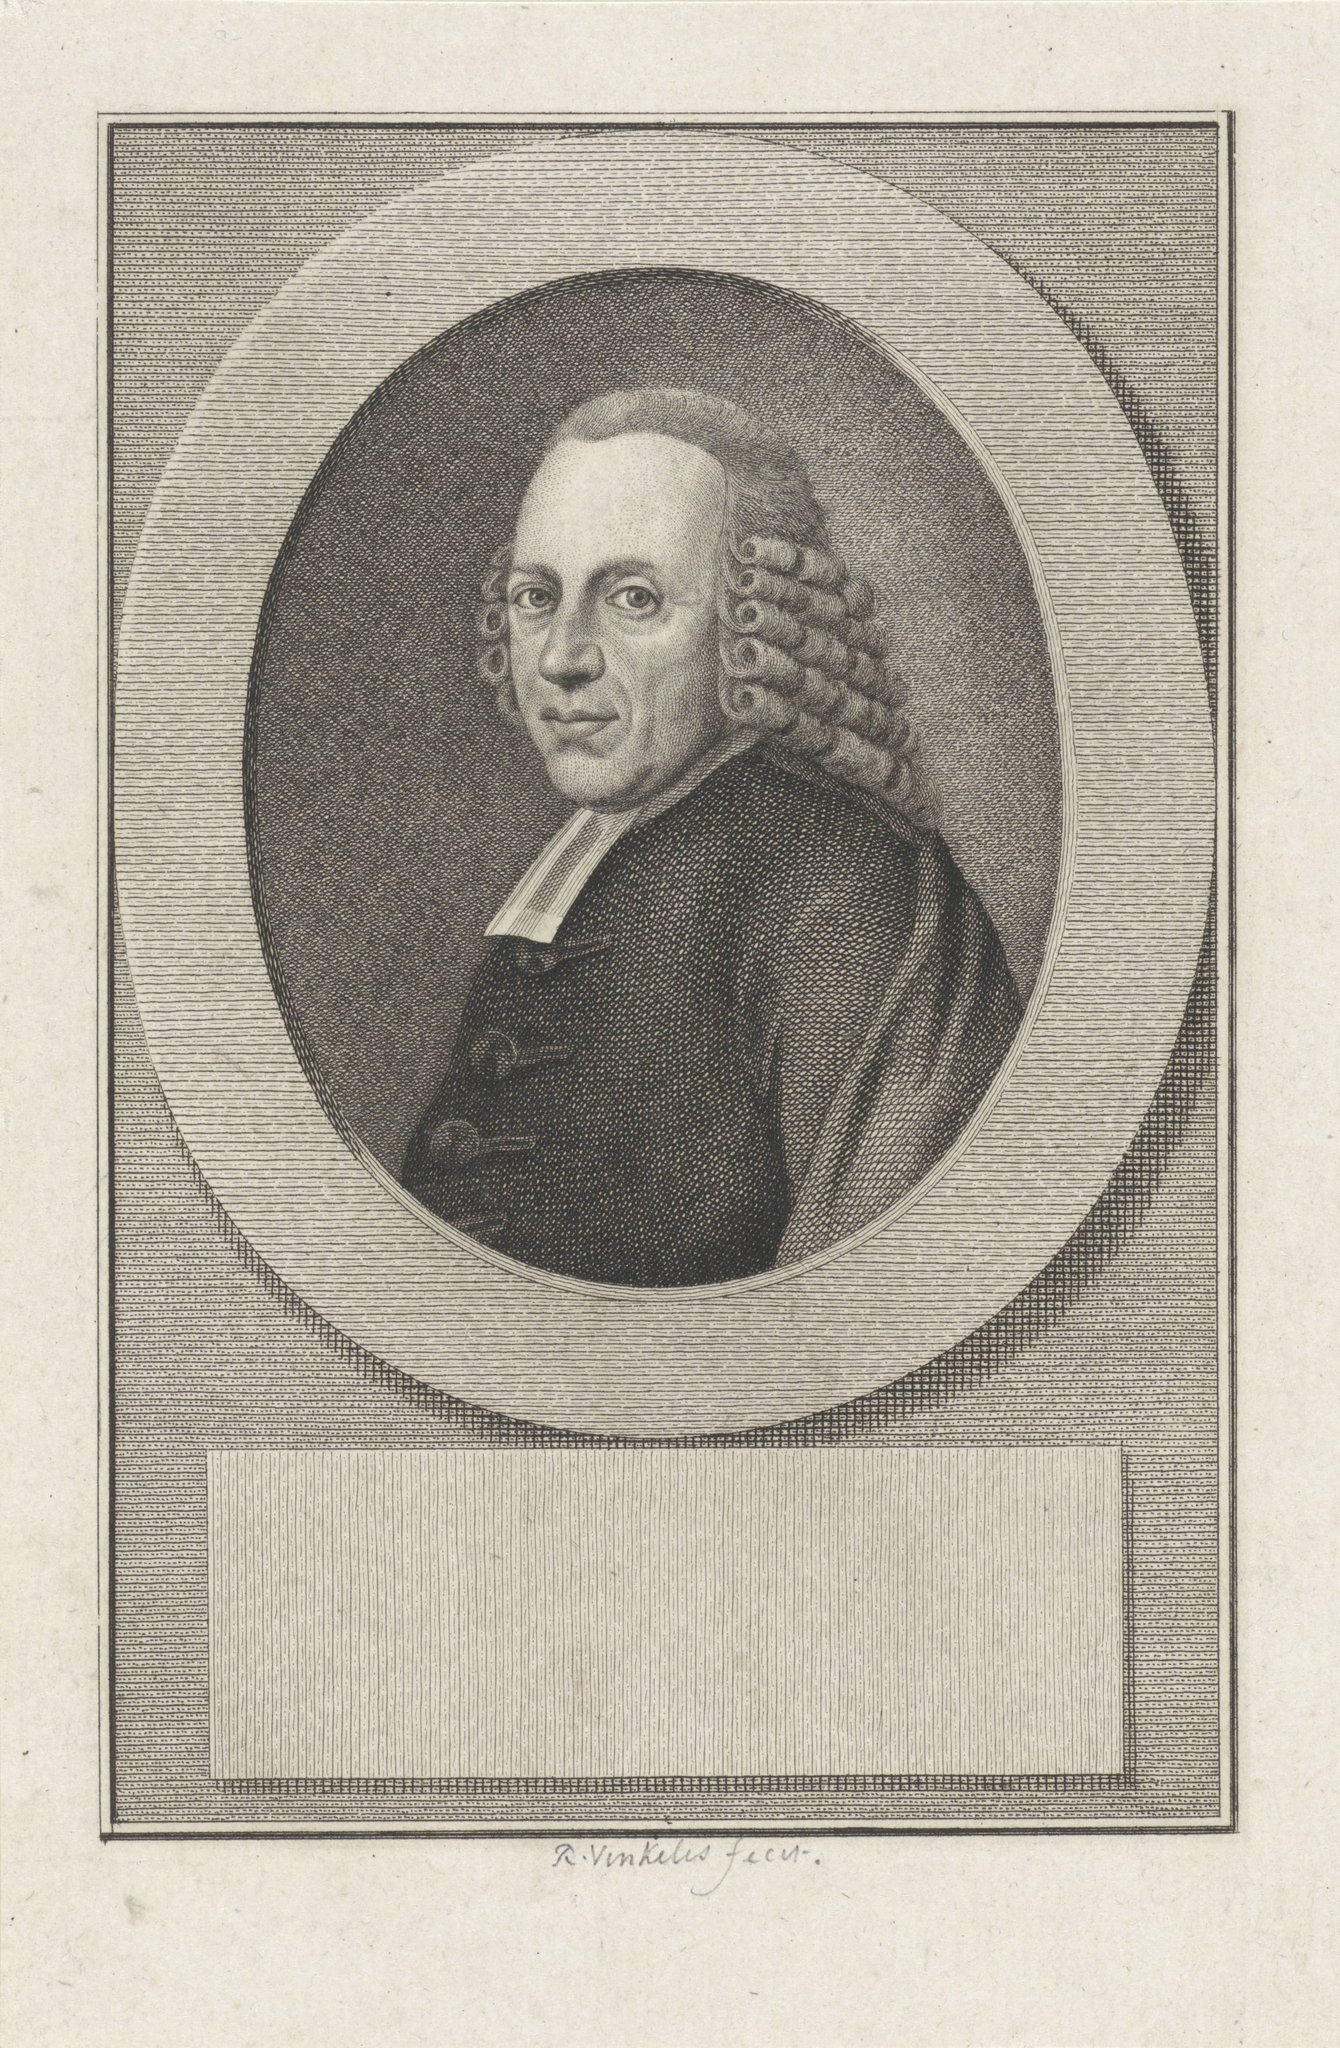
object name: print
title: Portret van Henricus van Herwerden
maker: reinier vinkeles (i)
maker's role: draughtsman, print maker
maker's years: 1741-1816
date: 1797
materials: paper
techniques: engraving, etching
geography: amsterdam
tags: predikant, henricus van herwerden (i)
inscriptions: collector's mark: Lugt 2228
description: Portret van de Amsterdamse predikant Henricus van Herwerden.